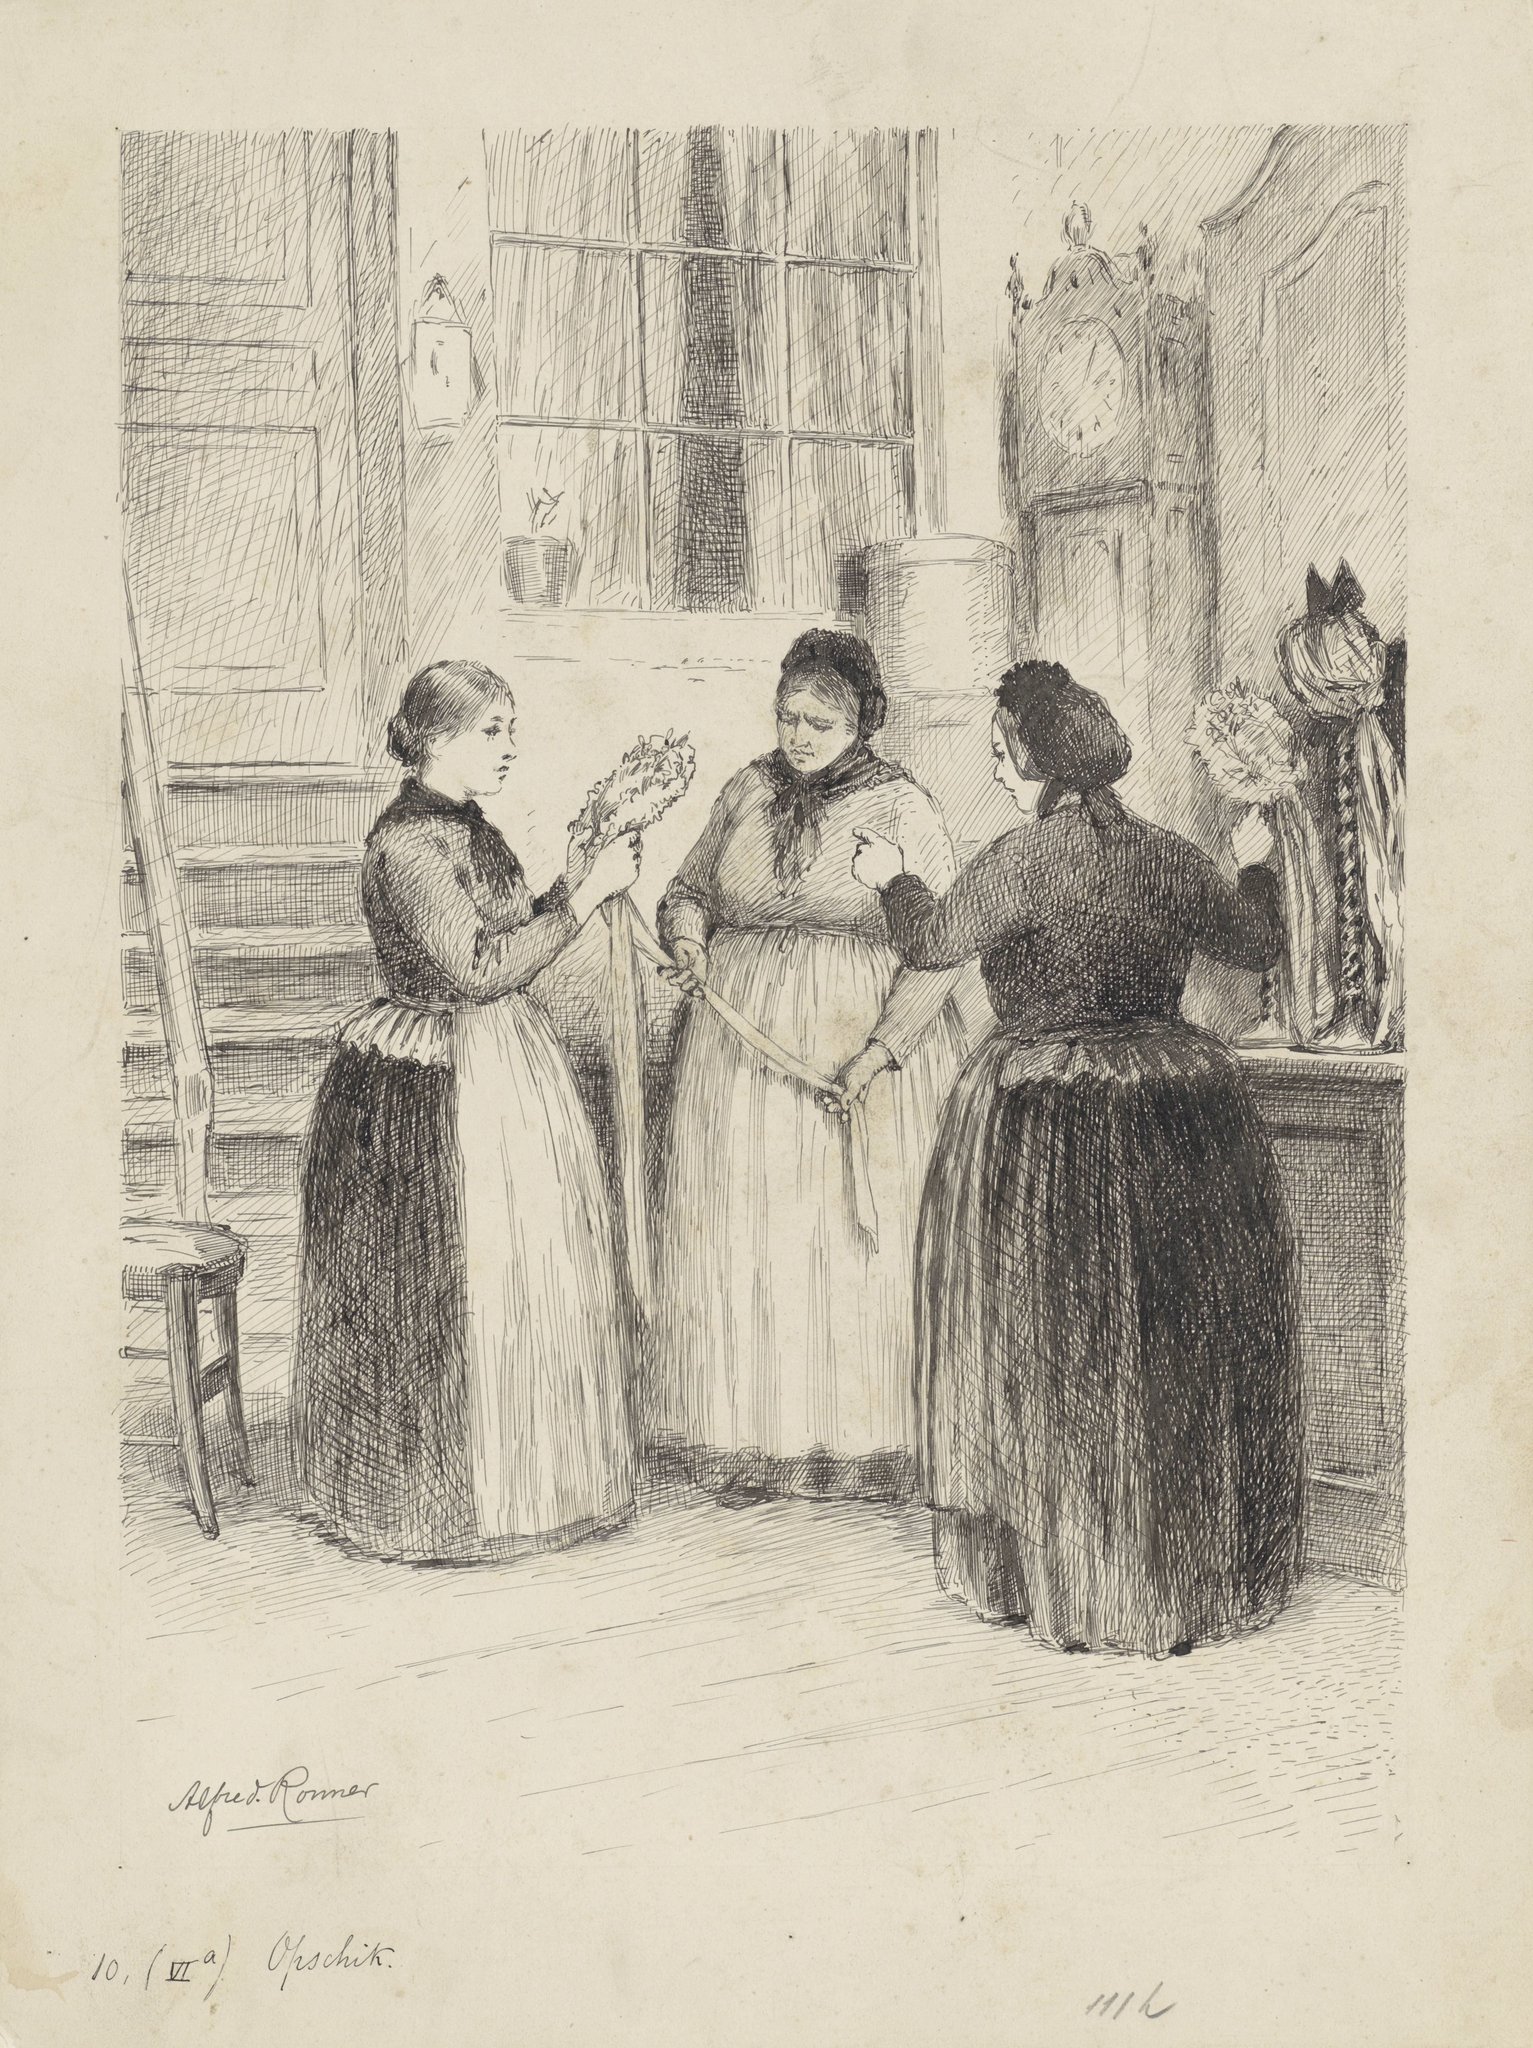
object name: drawing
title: Opschik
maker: alfred ronner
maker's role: draughtsman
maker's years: 1852-1901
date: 1893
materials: ink, paper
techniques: pen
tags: shop, store, (reiger, a.f.j., vluchtige schetsen uit het volksleven) specific works of literature (with author, title), head-gear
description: Illustratie voor 'Vluchtige Schetsen uit het Volksleven' door A.F.J. Reiger. Ontwerp voor een prent.